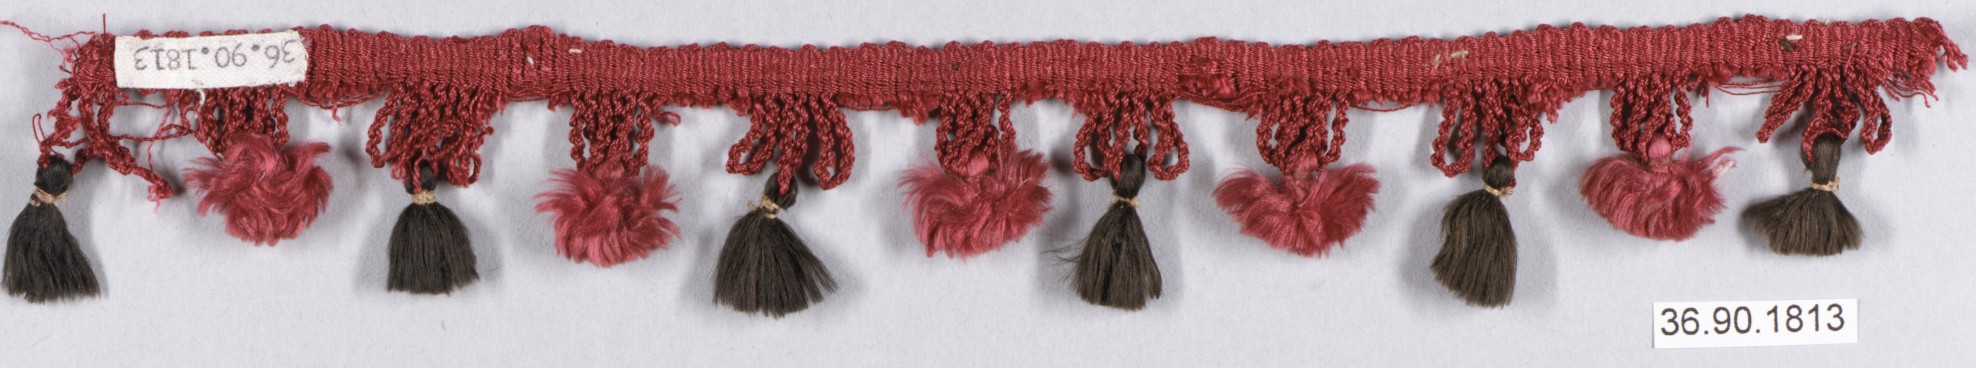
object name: fringe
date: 1750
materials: silk